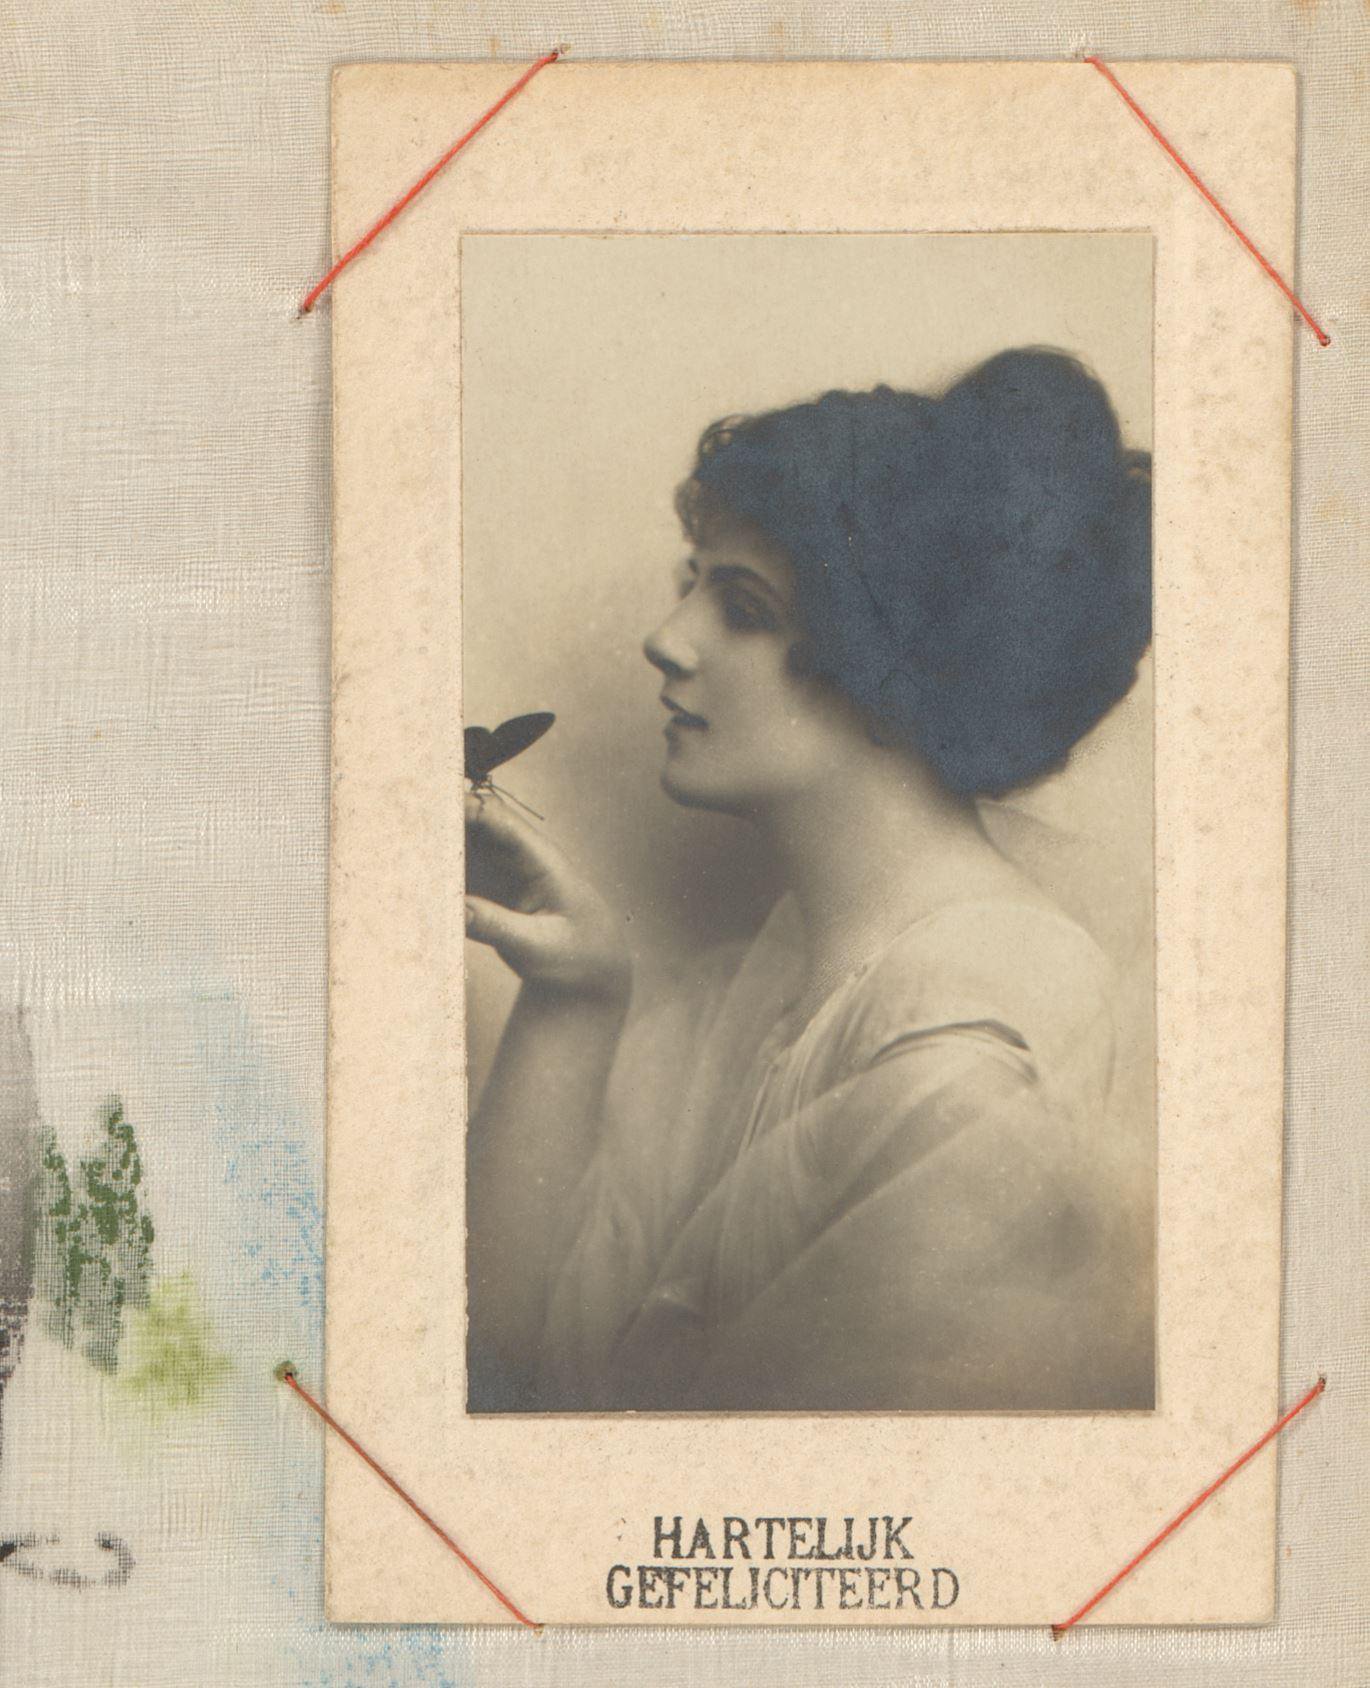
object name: ansichtkaart, prentbriefkaart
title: Hartelijk Gefeliciteerd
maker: Anonymous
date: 1880-1920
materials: paint, photographic support, silk, textile, watercolor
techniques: brush, gelatin silver print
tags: adult woman, historical persons